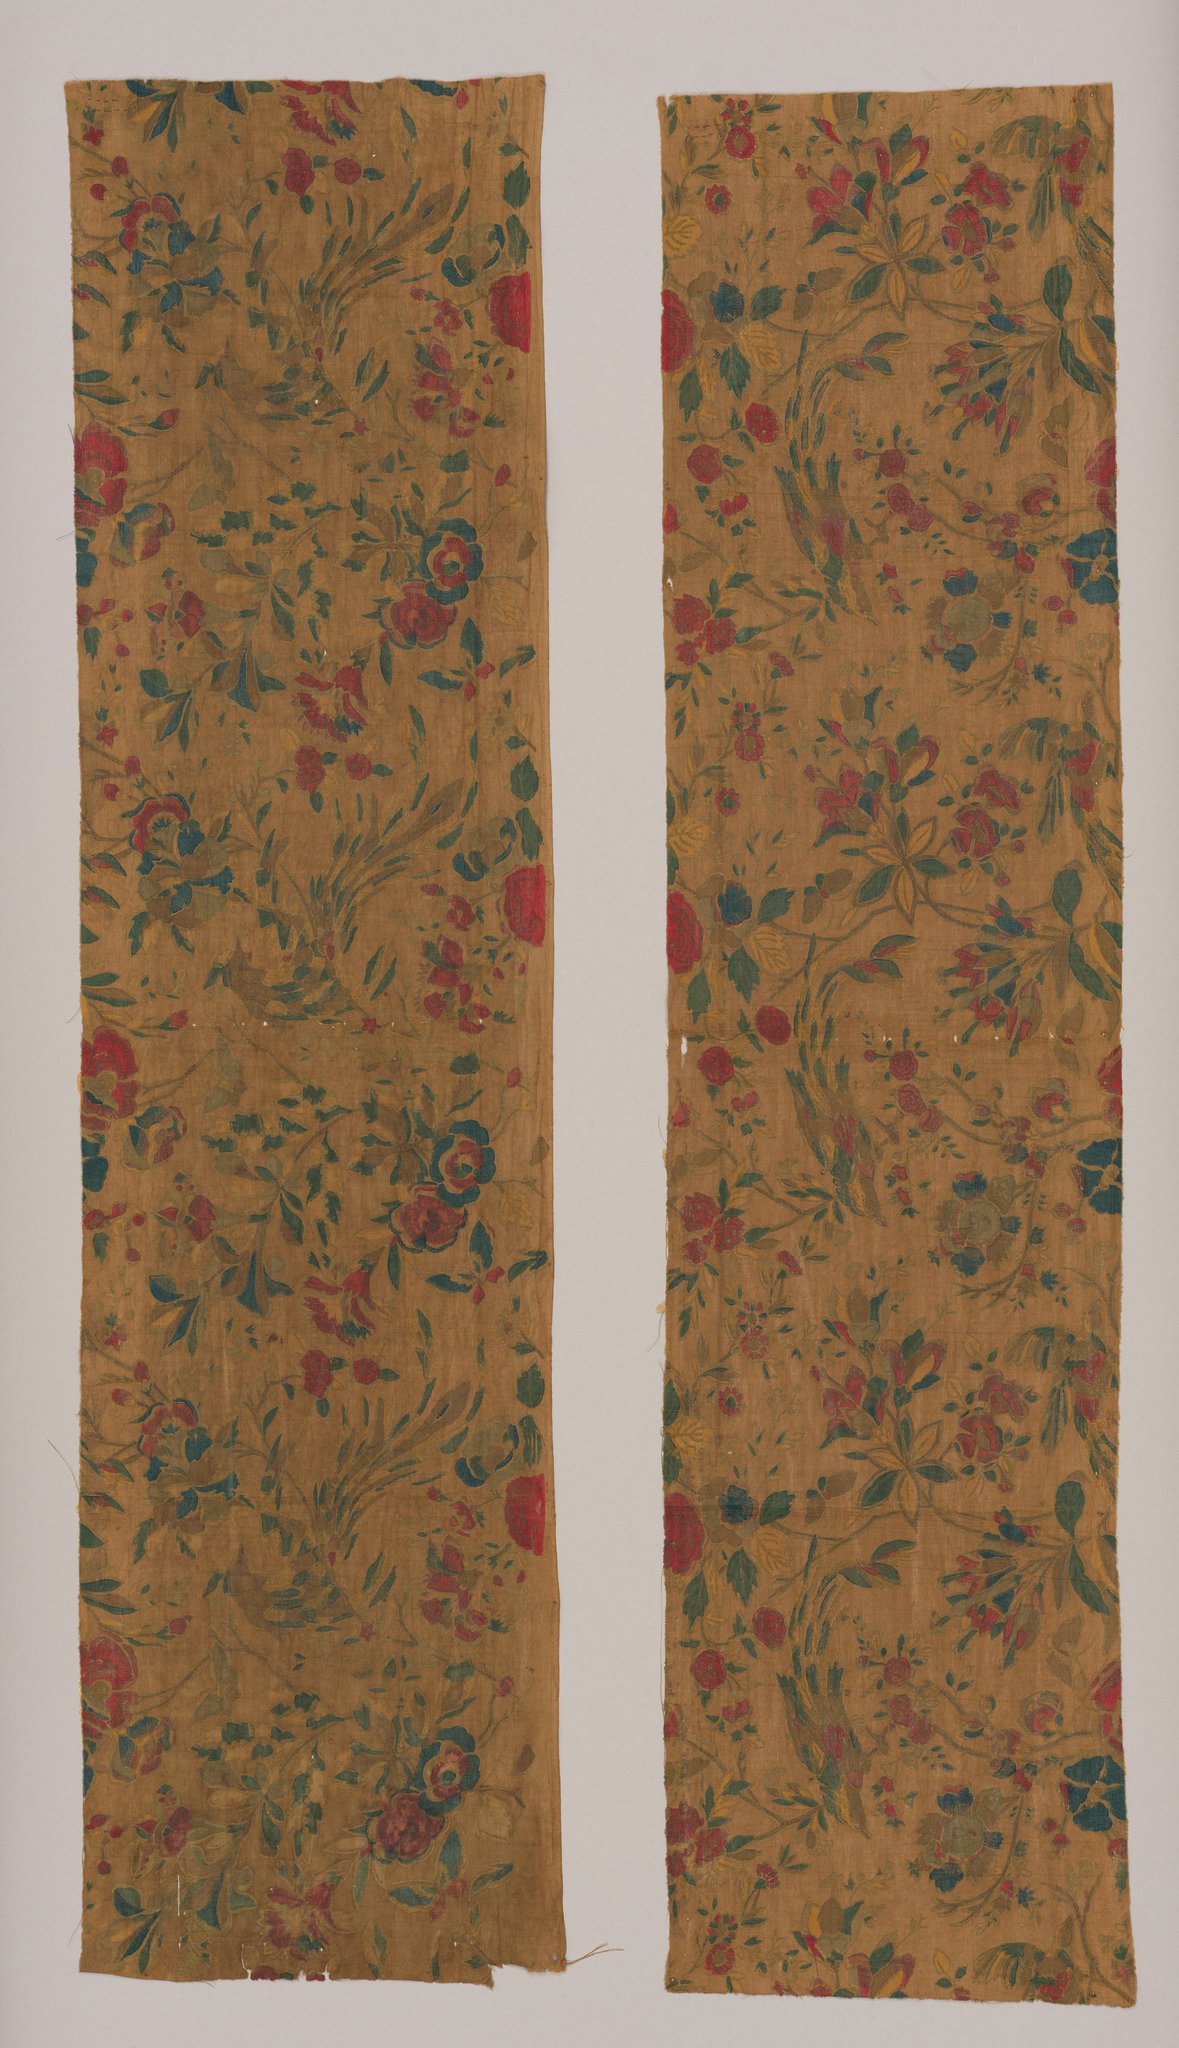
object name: fragment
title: Fragments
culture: japanese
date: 1701-1800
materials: cotton